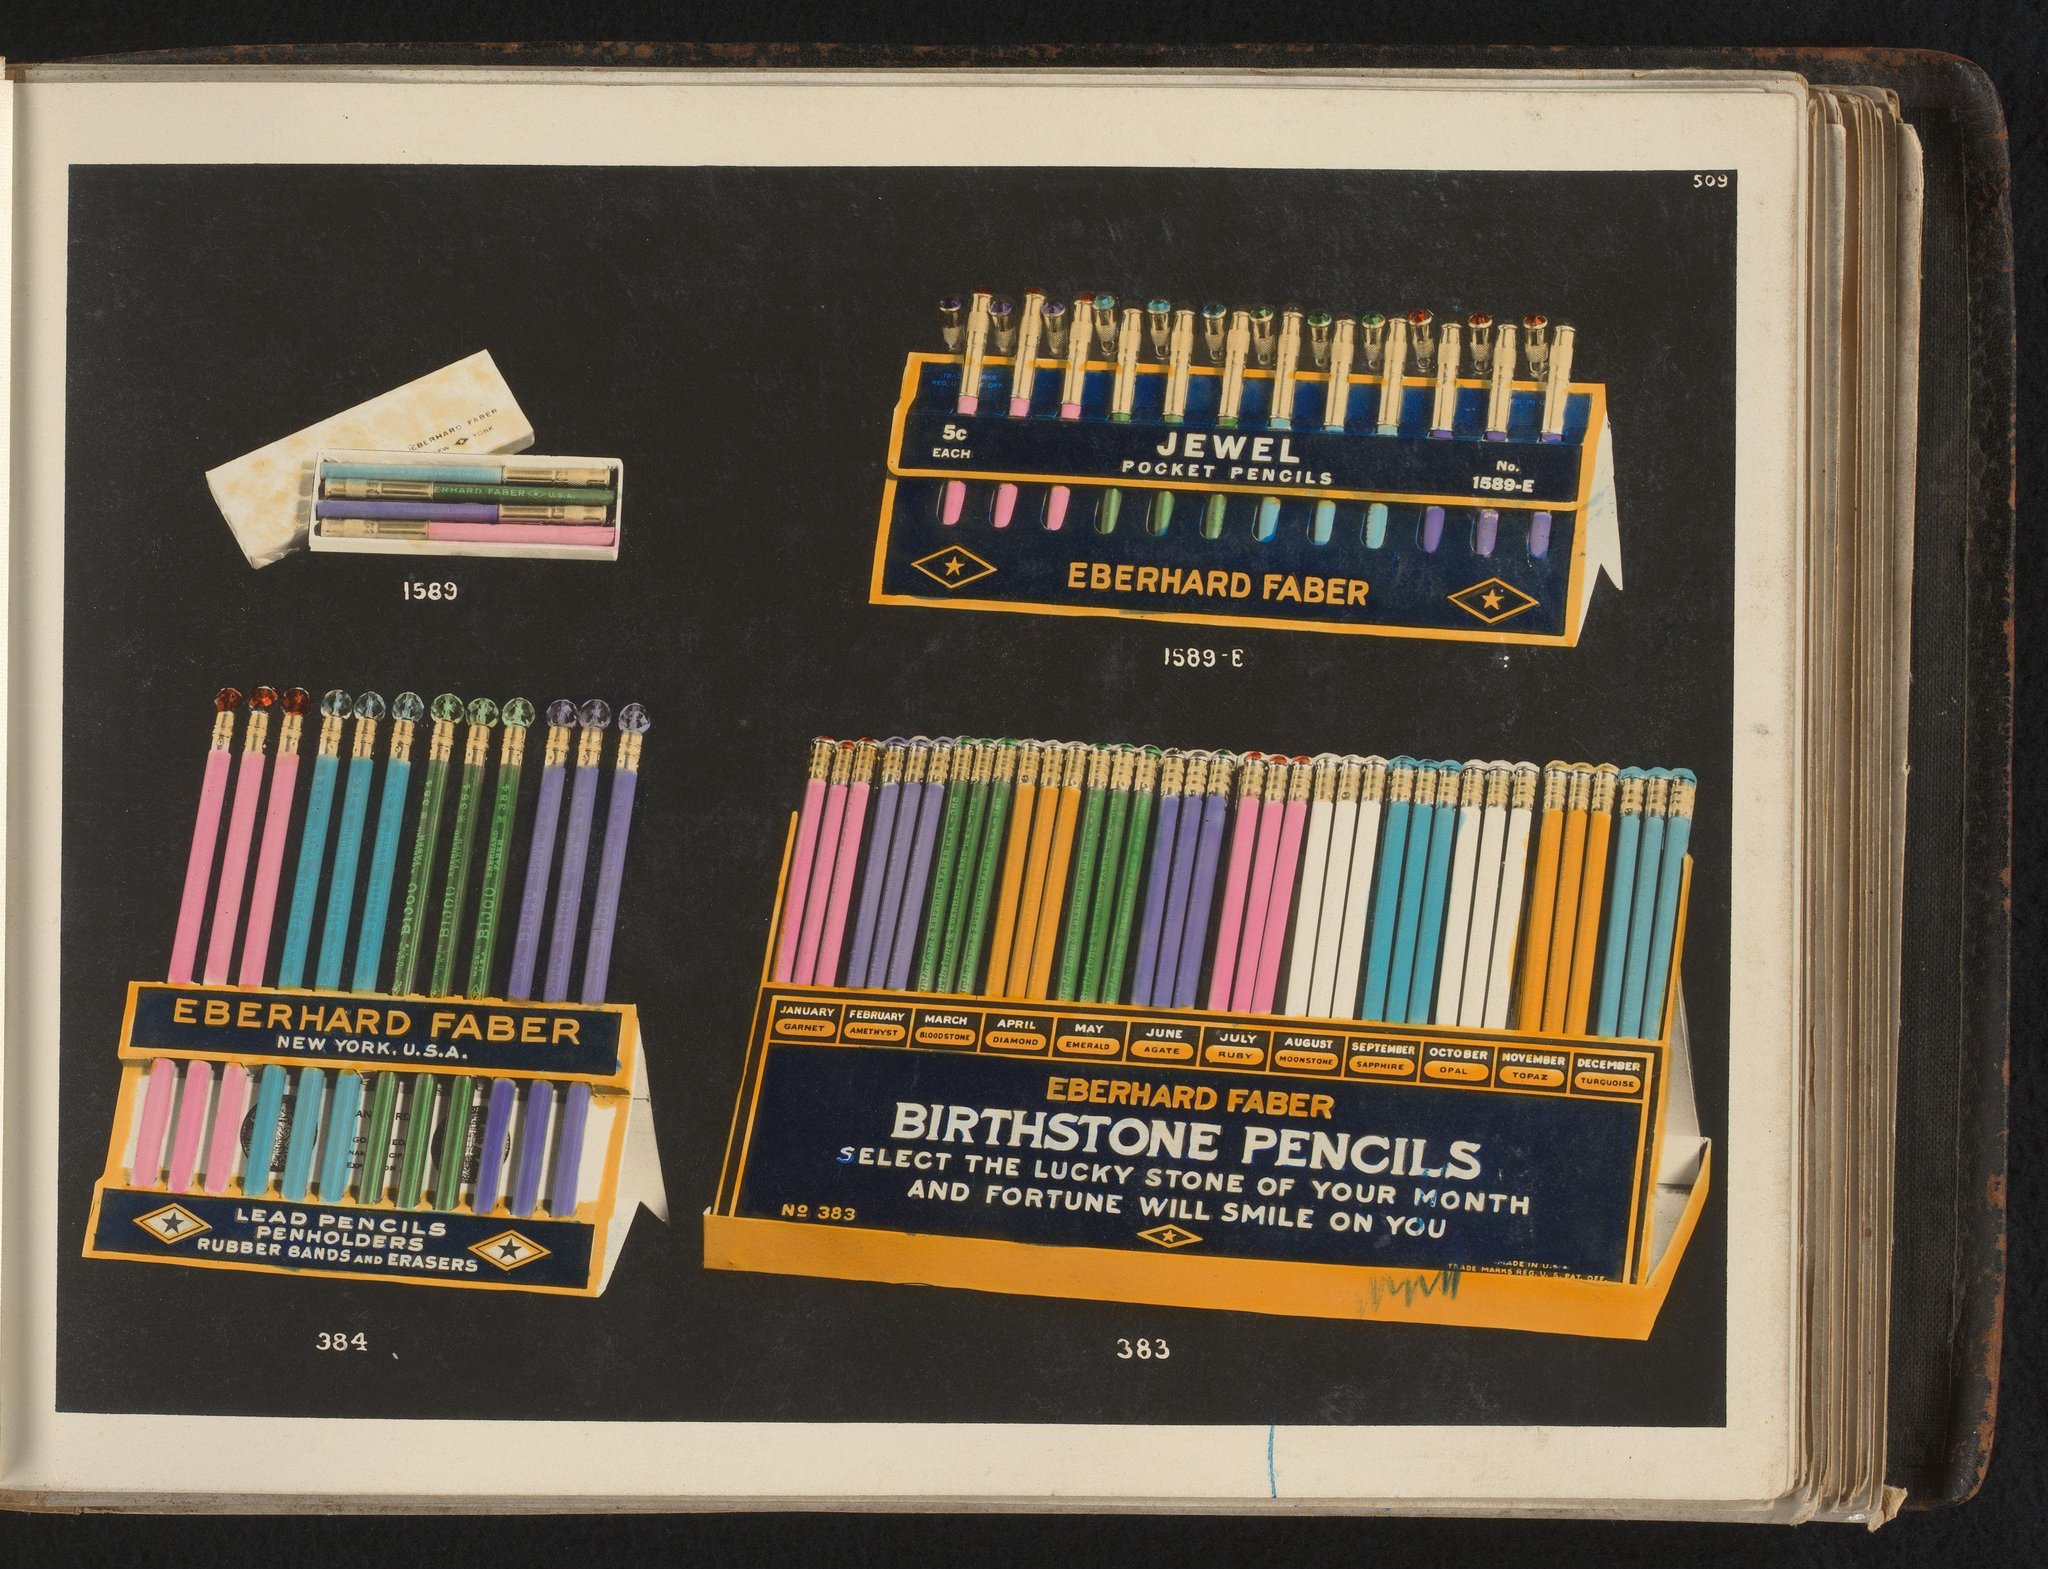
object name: photograph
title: Sets met potloden van Eberhard Faber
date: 1915-1935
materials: paper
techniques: gelatin silver print, hand coloring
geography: springfield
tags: pencil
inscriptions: number: ‘509’, stamp: ‘Paramount/ Commercial Studios/ 145 Chestnut St./ Springfield - Mass.’